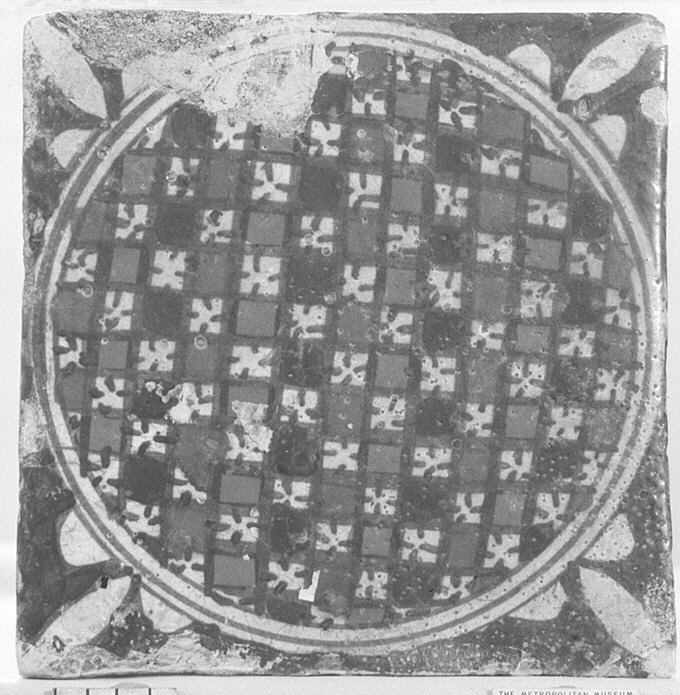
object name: floor tile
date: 1600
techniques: maiolica, glazing